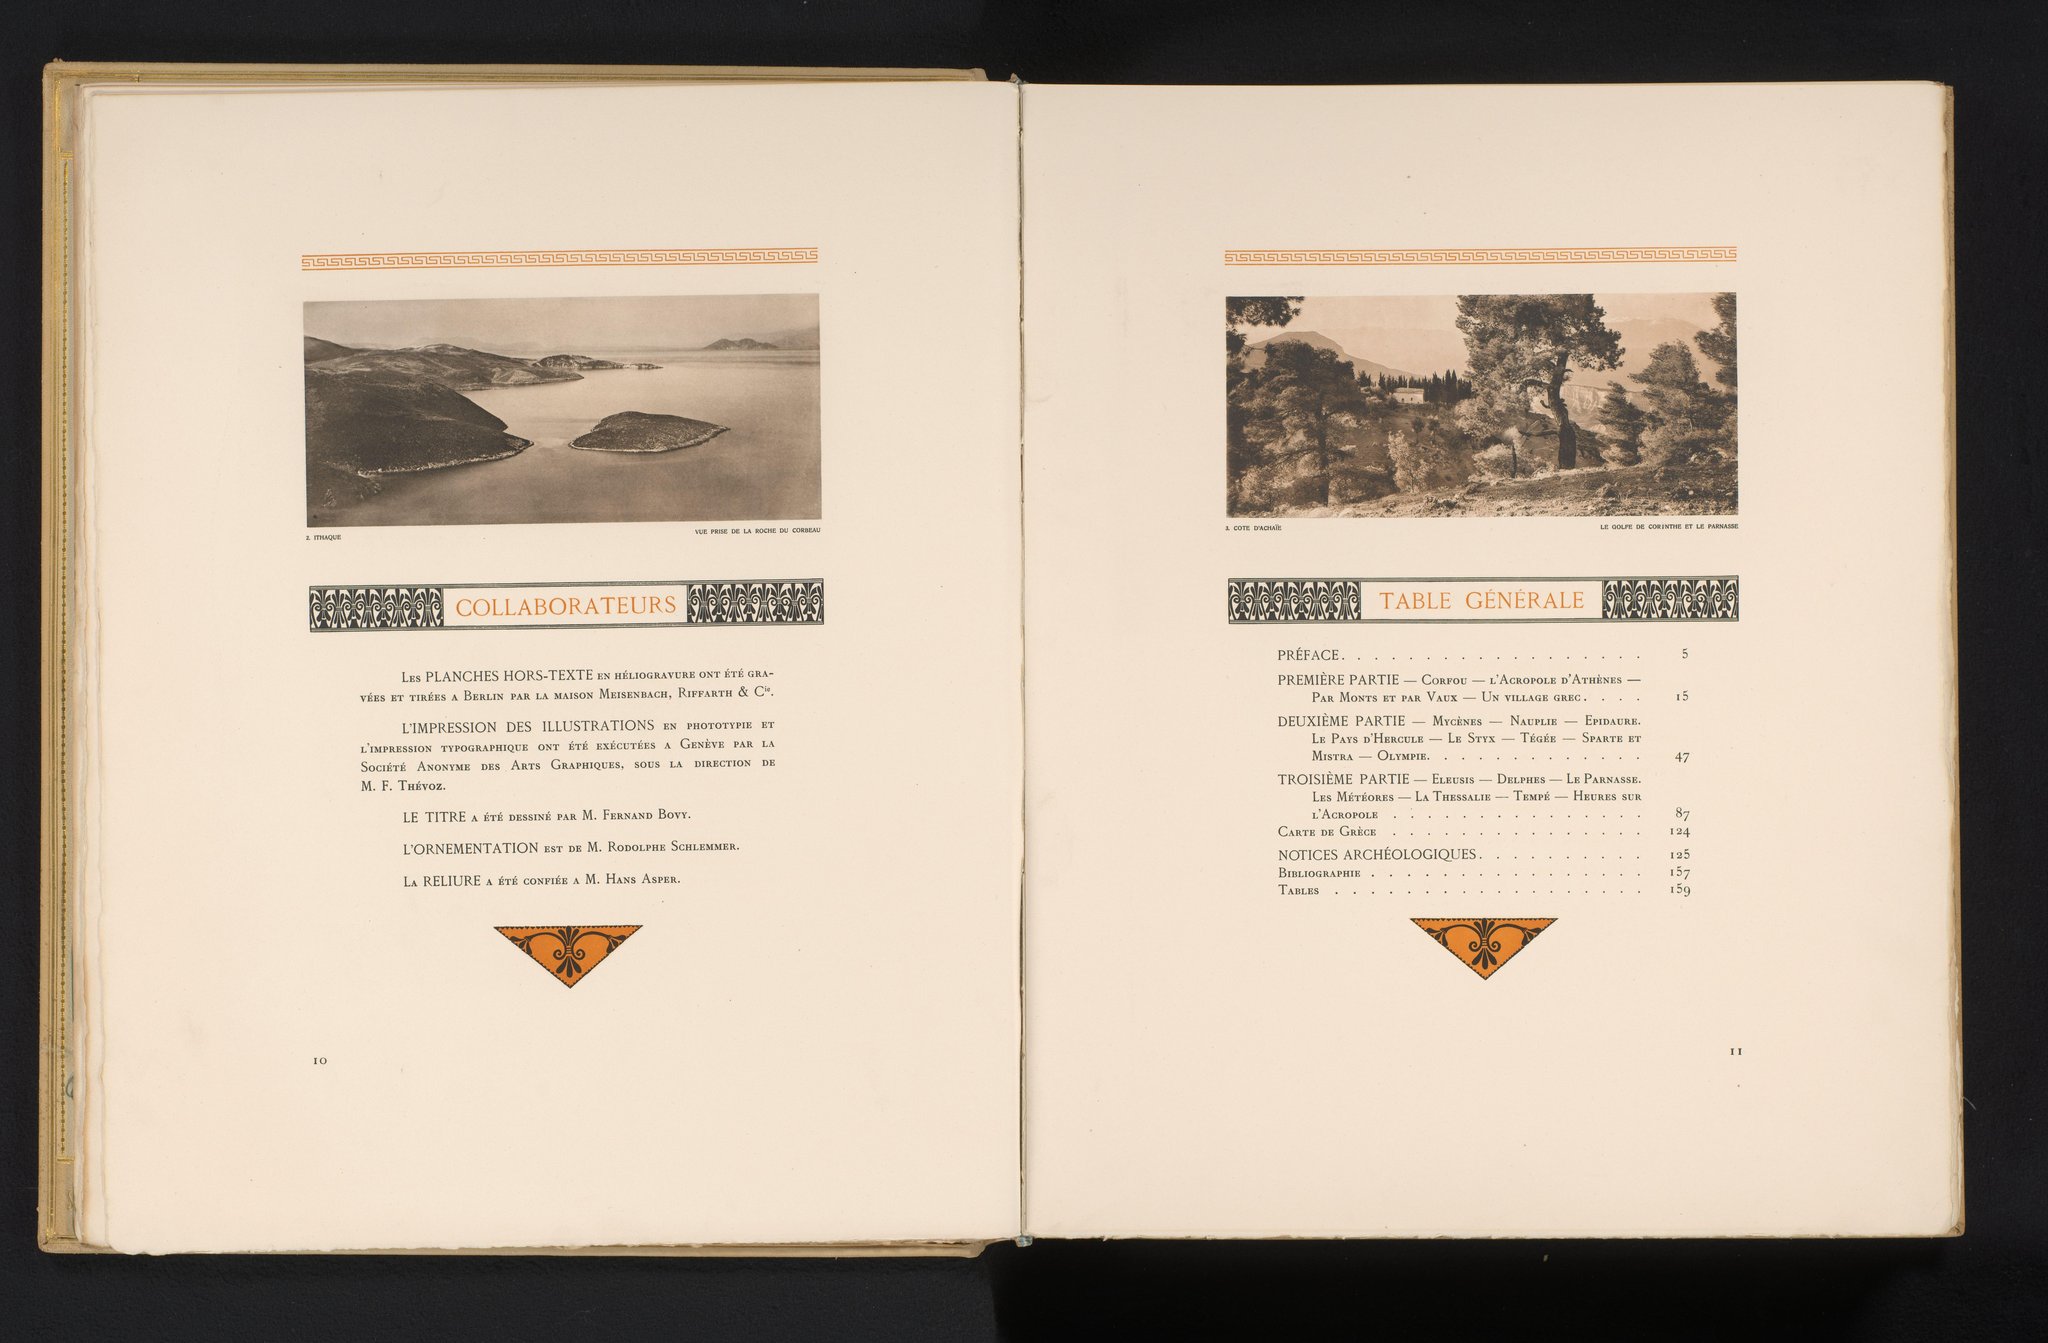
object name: page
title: Gezicht op voormalig Frans departement Itaque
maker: frédéric boissonnas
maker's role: fotograaf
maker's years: 1858-1946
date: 1905-1910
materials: paper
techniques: photograph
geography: berlin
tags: island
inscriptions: number: ‘2.’